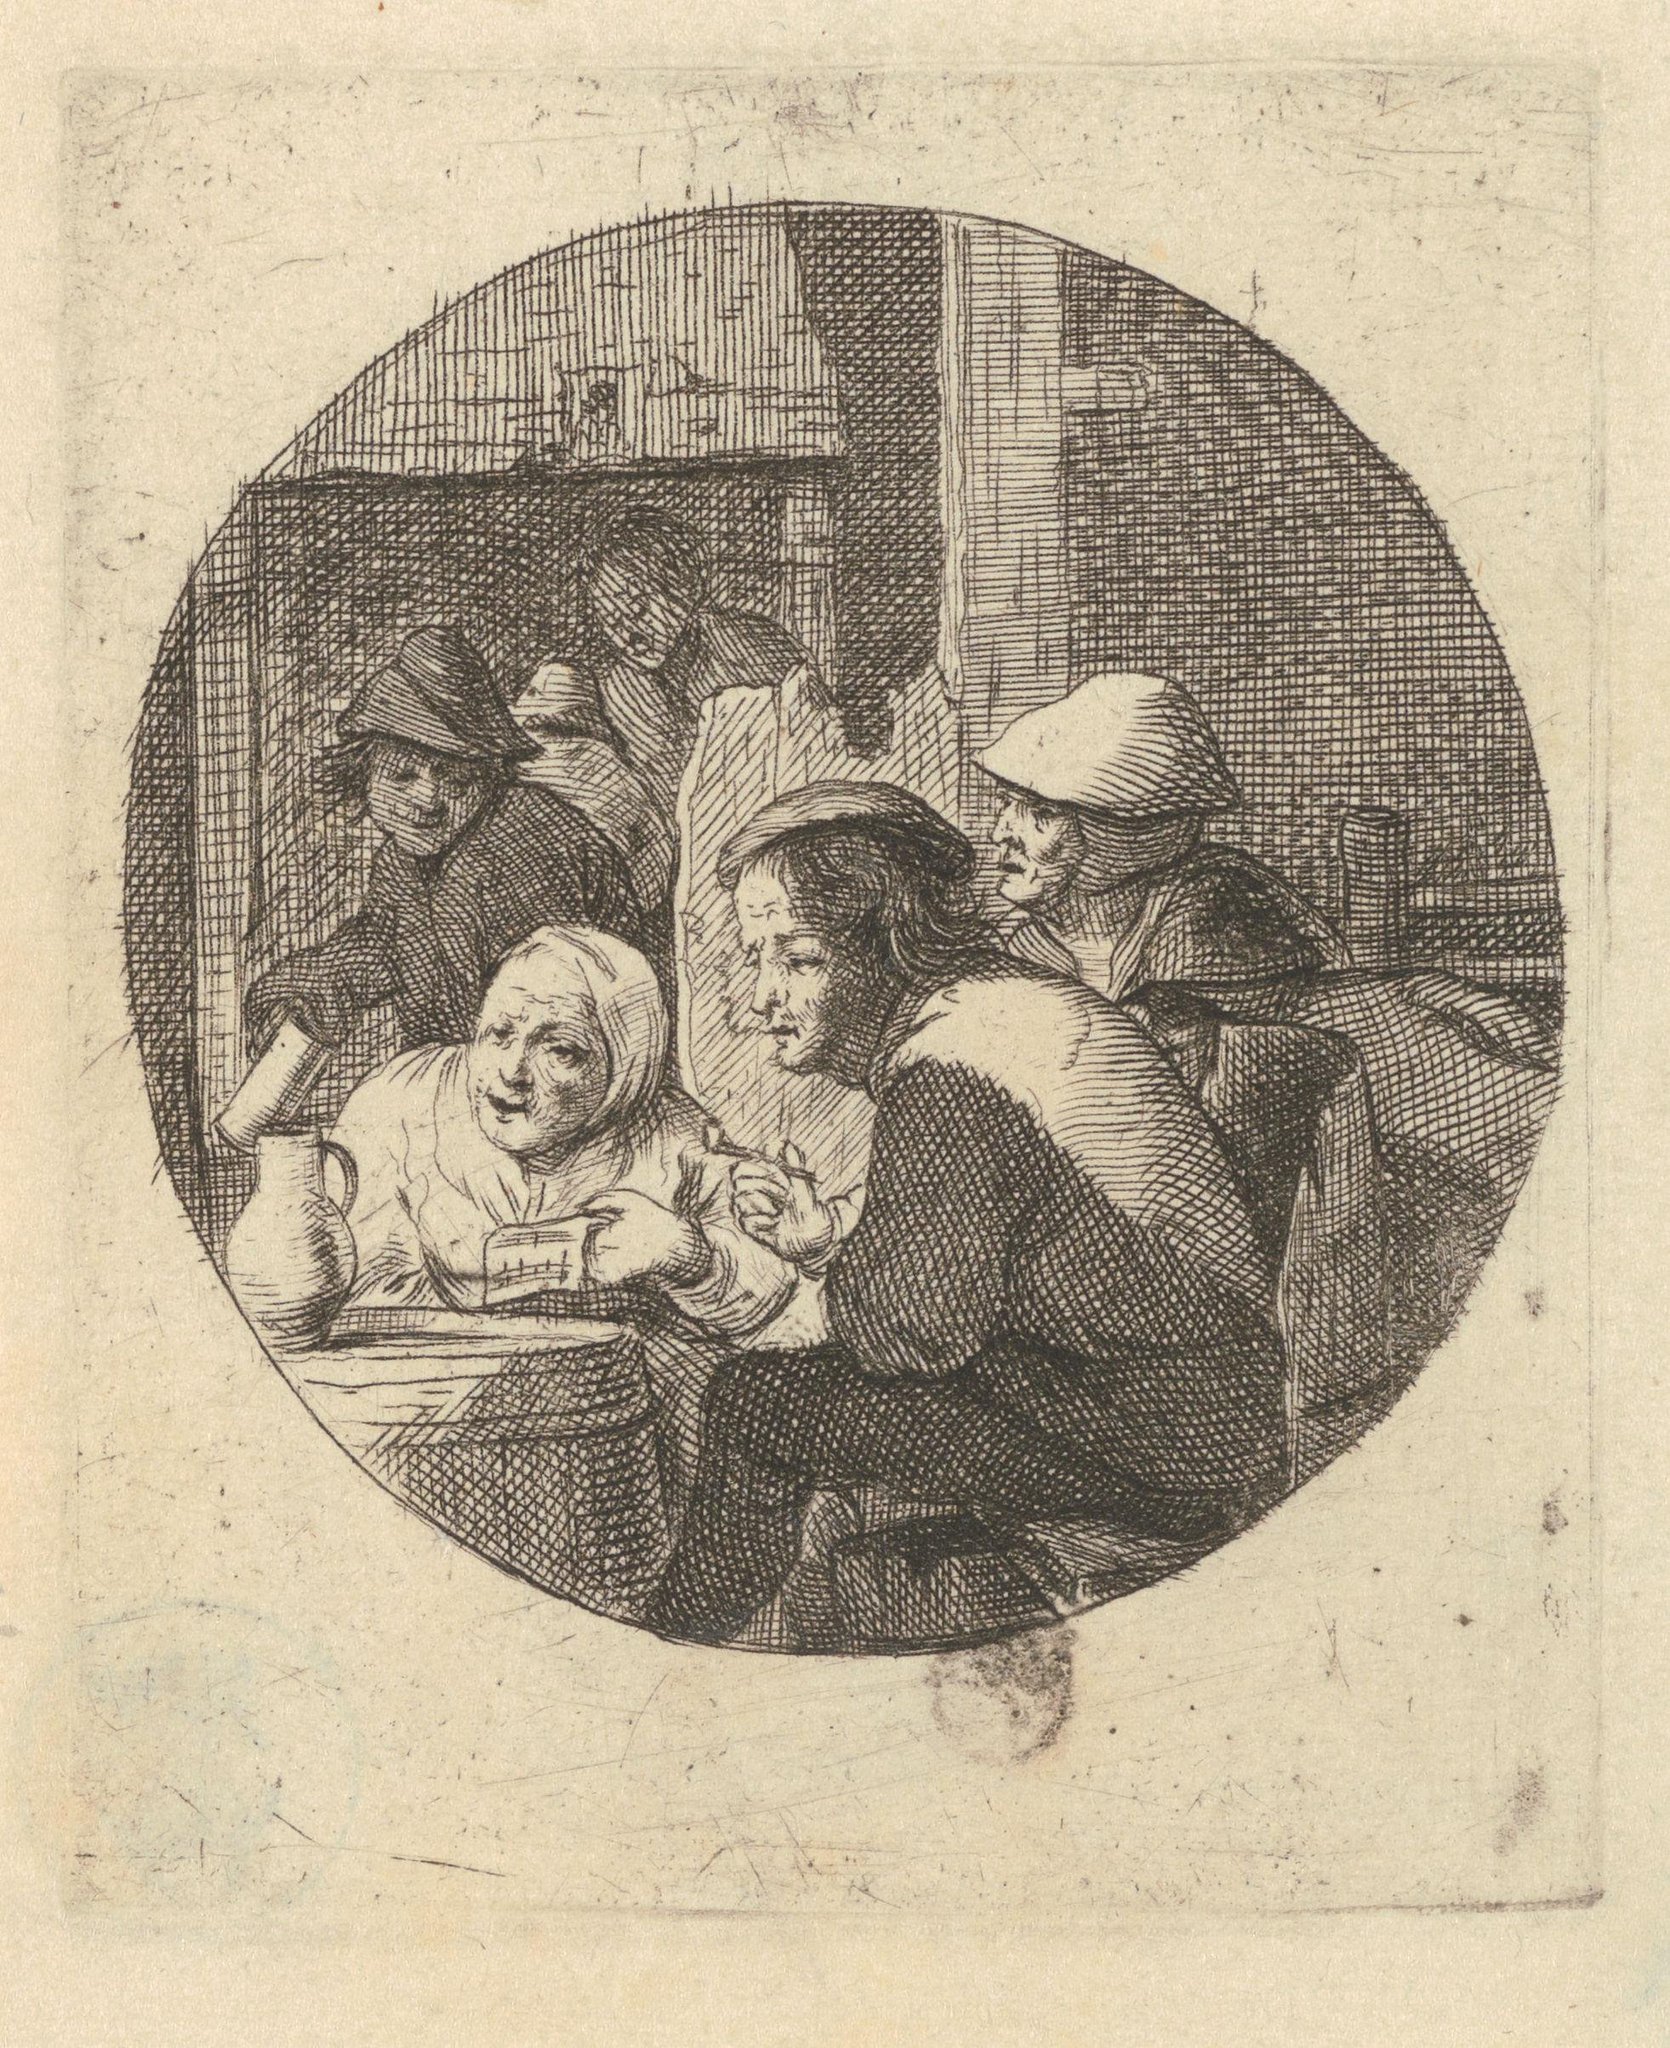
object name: print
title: Herberginterieur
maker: Anonymous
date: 1600-1700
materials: paper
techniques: engraving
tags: inn, coffee-house, public house, etc.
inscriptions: inscription: ‘mieux que Dassonville mais qui?’, collector's mark: Lugt 514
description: Herberginterieur met een rokende boer en een oude vrouw met bladmuziek in haar hand.